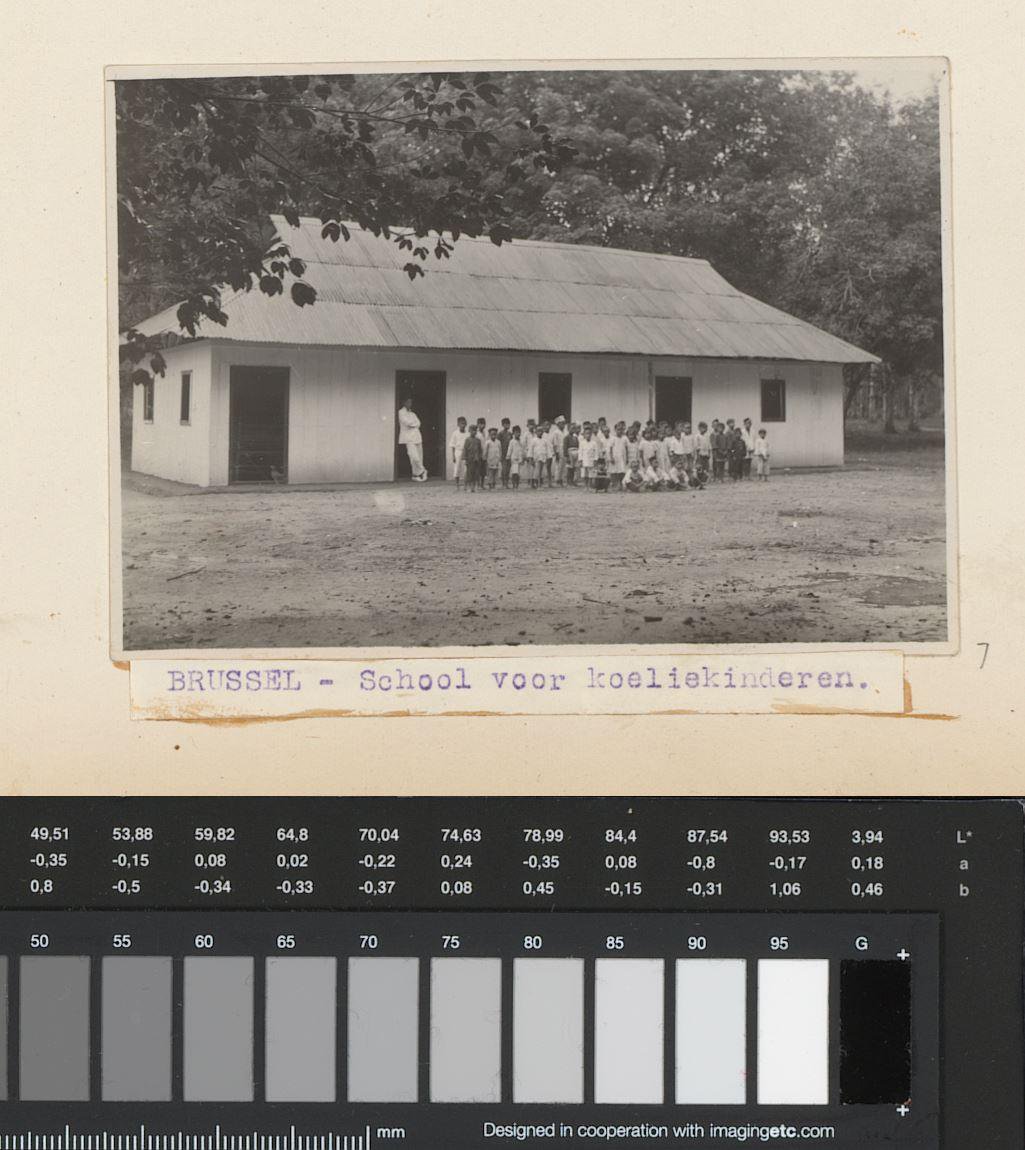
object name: photograph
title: Brussel - School voor koeliekinderen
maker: Anonymous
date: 1925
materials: photographic support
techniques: gelatin silver print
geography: east sumatra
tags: plantation, (non-fruit) products of plants or trees: rubber, working class, labourers, elementary school; class, form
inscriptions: inscription: ‘Brussel - School voor koeliekinderen’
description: Kinderen van contractarbeiders op de plantage Brussel poseren met een onderwijzer voor het schoolgebouw. Onderdeel van het fotoalbum over de plantages Brussel en Pernantian van de Sumatra Caoutchouc Maatschappij op de Oostkust van Sumatra in de jaren 1910-1935.